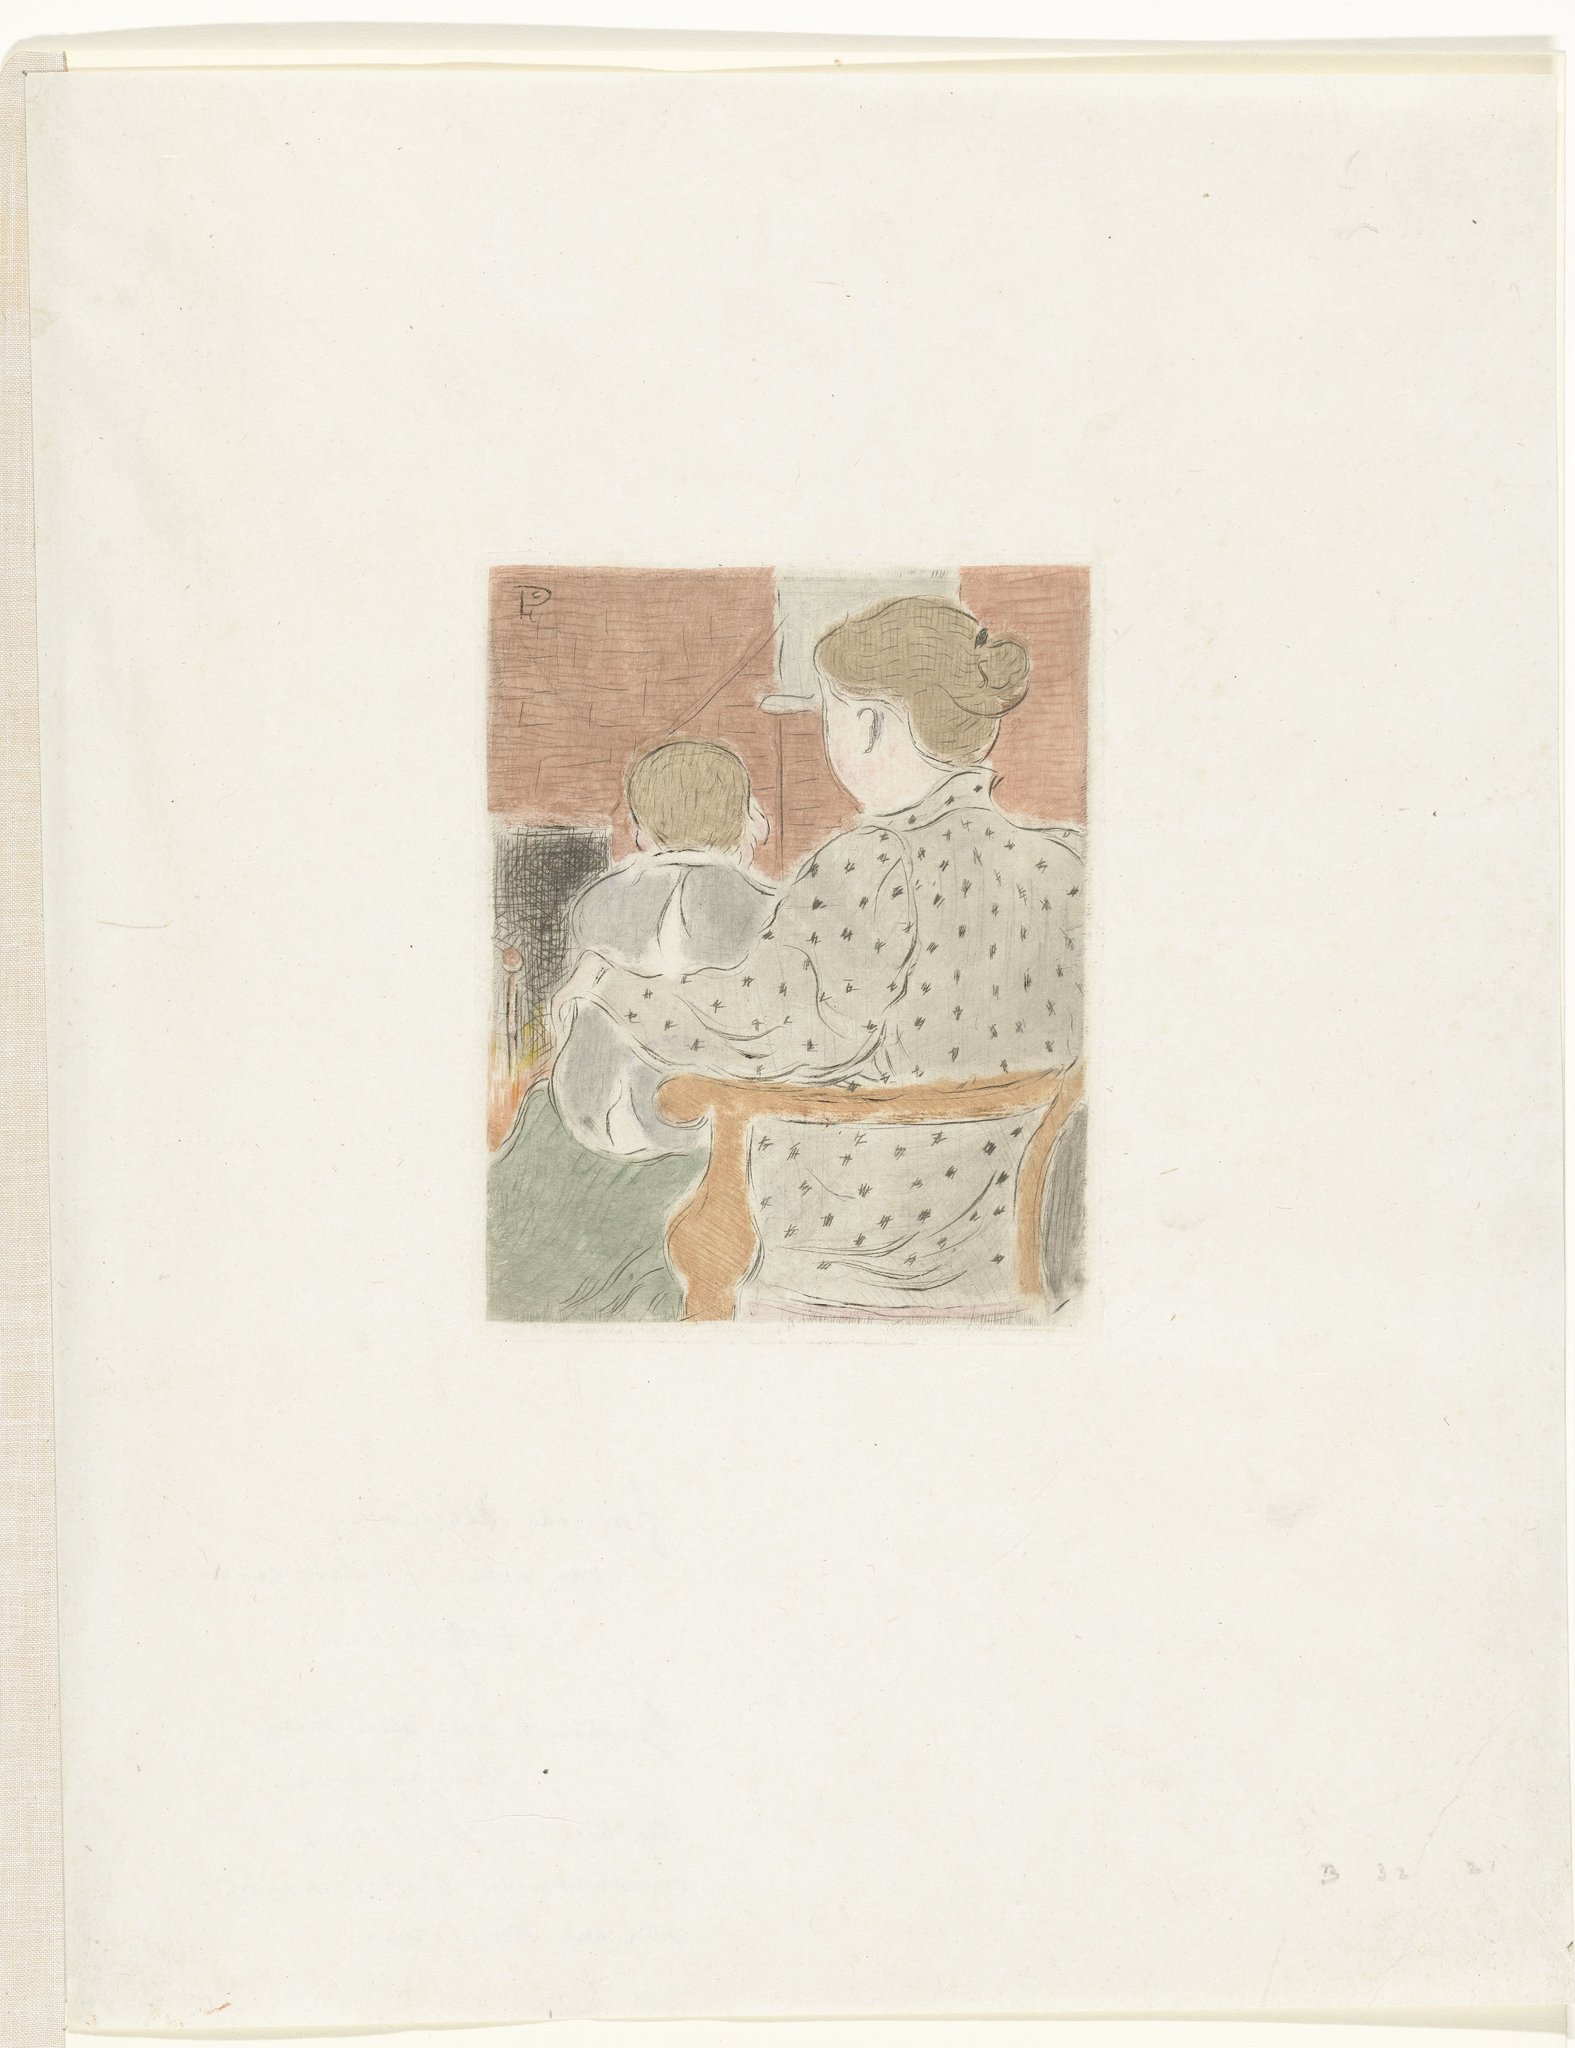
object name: print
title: Moeder met kind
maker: lucien pissarro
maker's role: painter, print maker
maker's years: 1863-1944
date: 1915-1925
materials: paper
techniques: printing, drypoint, lithography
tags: mother and baby or young child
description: Moeder met een kind op schoot, op de rug gezien.